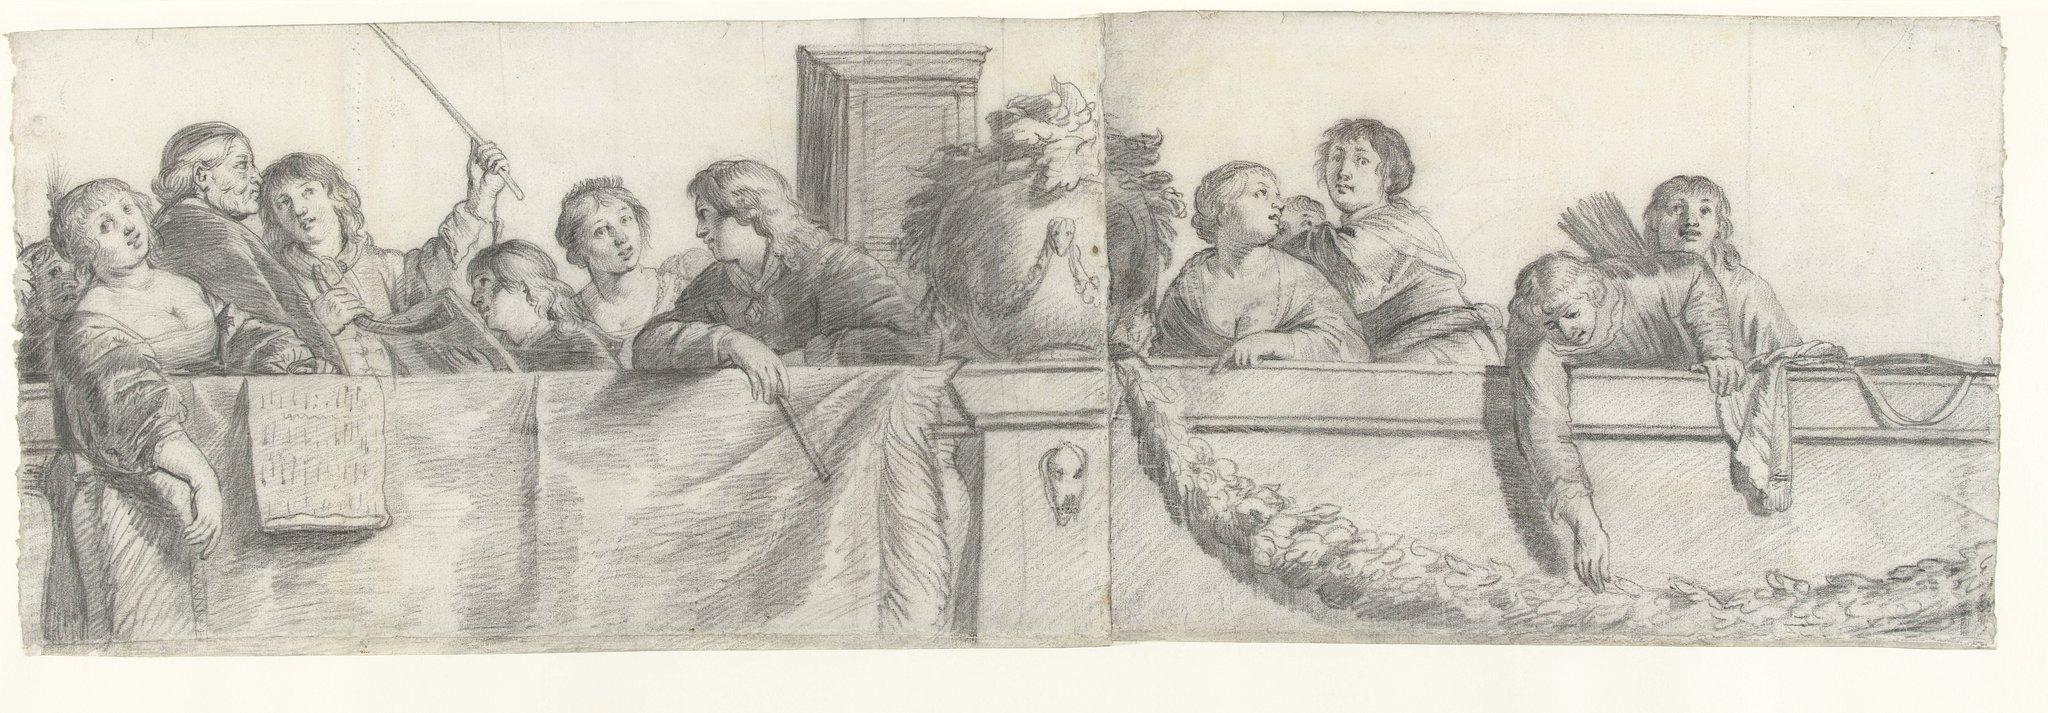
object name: drawing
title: Personen op een balustrade met festoenen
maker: cornelis holsteyn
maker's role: draughtsman, painter, print maker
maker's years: 1618-1658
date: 1633-1638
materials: chalk, paper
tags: balustrade, vocal music, singing